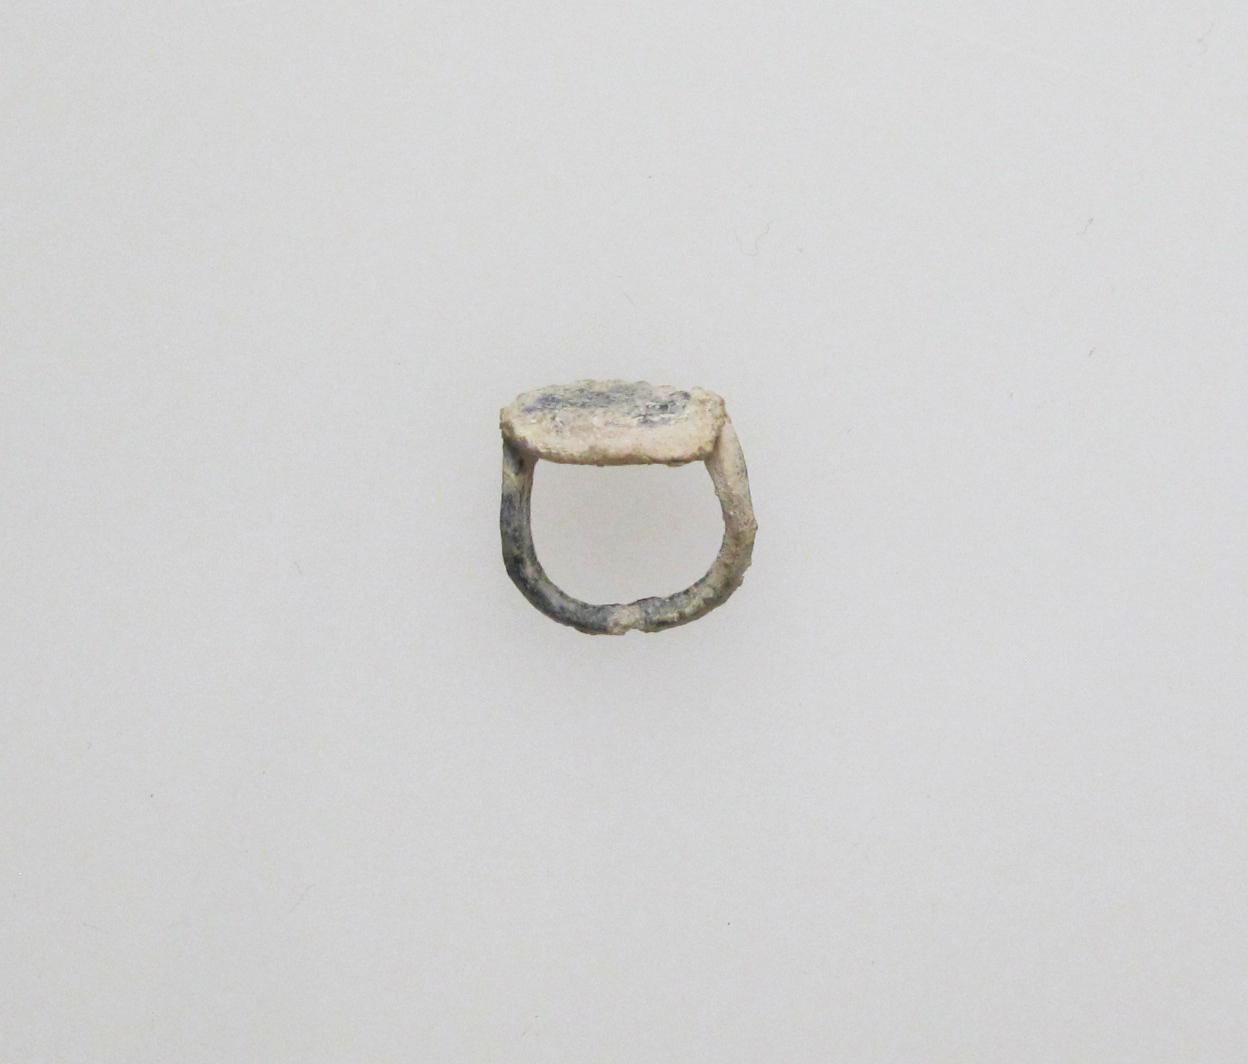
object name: ring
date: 7000 BCE-330 CE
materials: lead